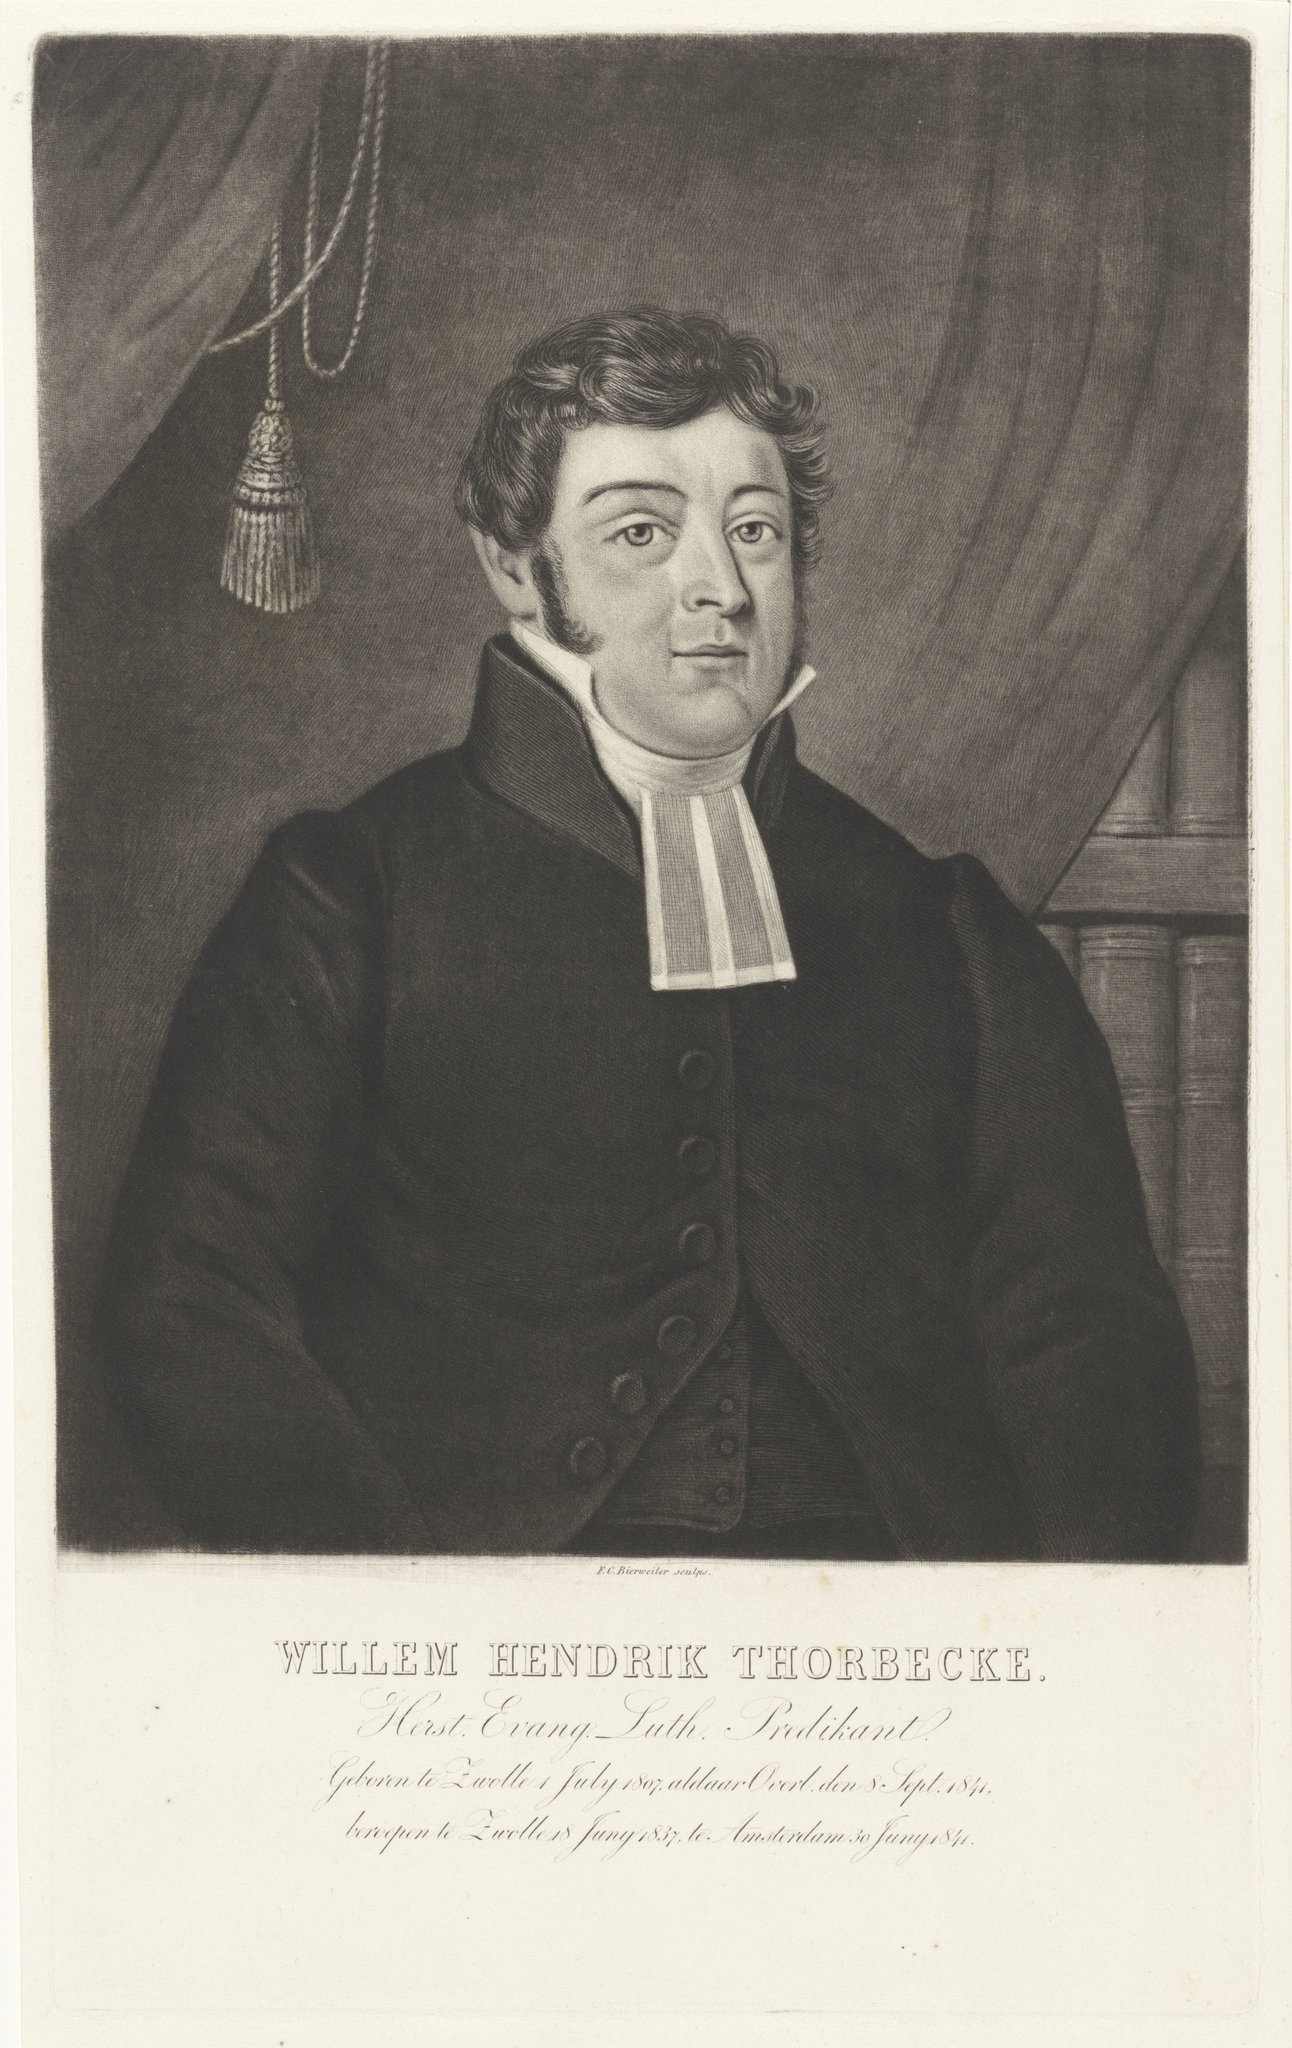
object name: print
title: Portret van Willem Hendrik Thorbecke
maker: frederik christiaan bierweiler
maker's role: print maker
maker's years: 1783-1831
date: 1841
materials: paper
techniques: engraving, etching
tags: study; 'studiolo'; library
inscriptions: collector's mark: Lugt 2228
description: Portret van Willem Hendrik Thorbecke in zijn studeerkamer. Hij was predikant van de Hersteld Evangelische Gemeente te Zwolle.